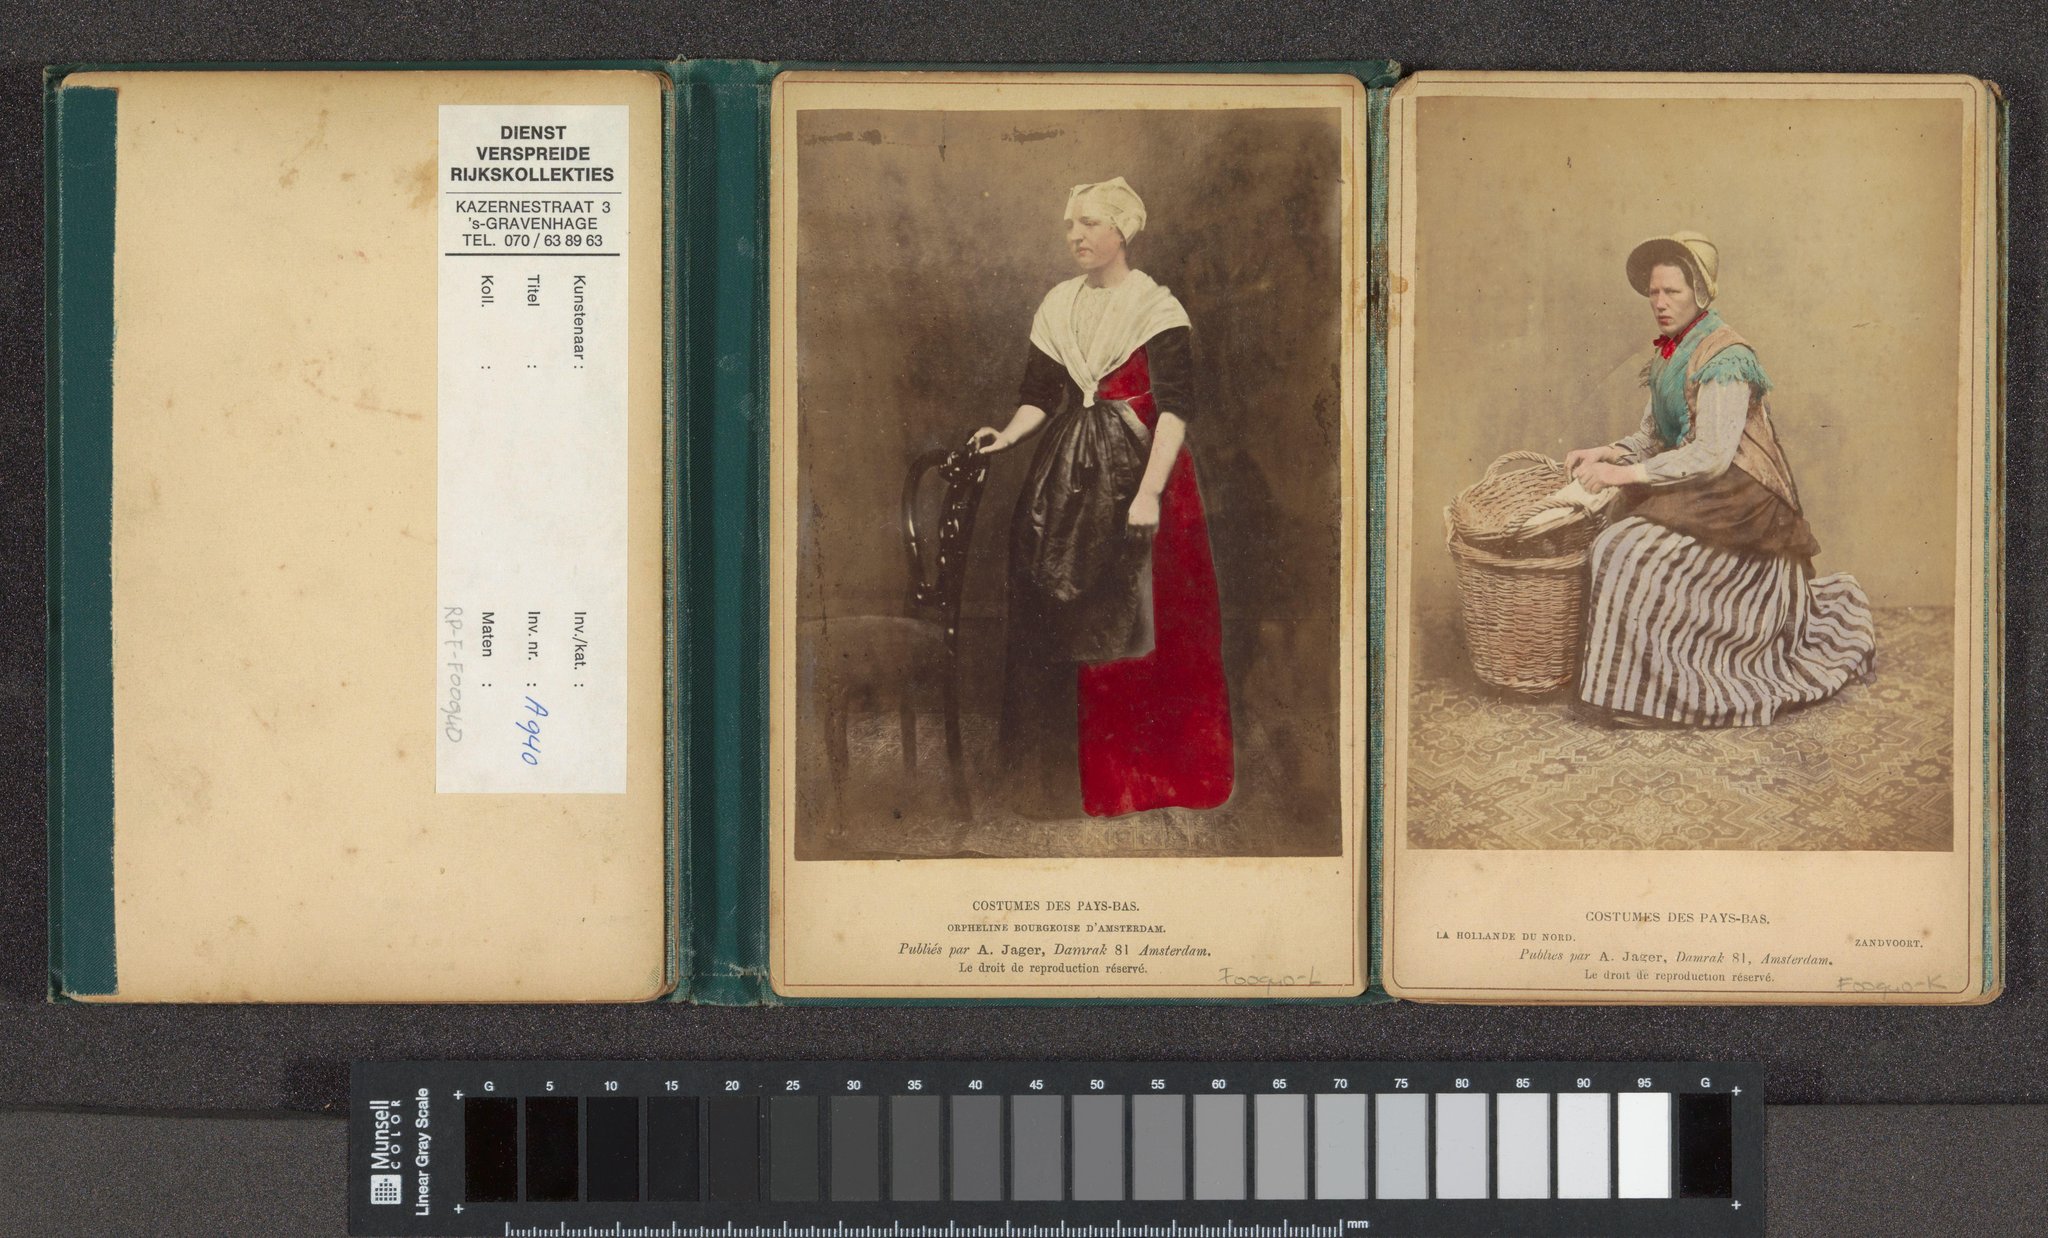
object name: photograph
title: Orpheline Bourgeoise d'Amsterdam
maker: andries jager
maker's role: publisher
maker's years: 1825-1905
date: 1870-1890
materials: cardboard, paper, photographic support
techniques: albumen print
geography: amsterdam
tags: folk costume, regional costume (+ women's clothes), studio requisites ~ photographer, folk costume, regional costume, orphans, amsterdam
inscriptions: inscription: ‘Costumes des Pays-Bas. Publiés par A. Jager, Damrak 81 Amsterdam Le droit de reproduction réservé.’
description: Onderdeel van Fotoalbum met klederdrachten van Nederland.